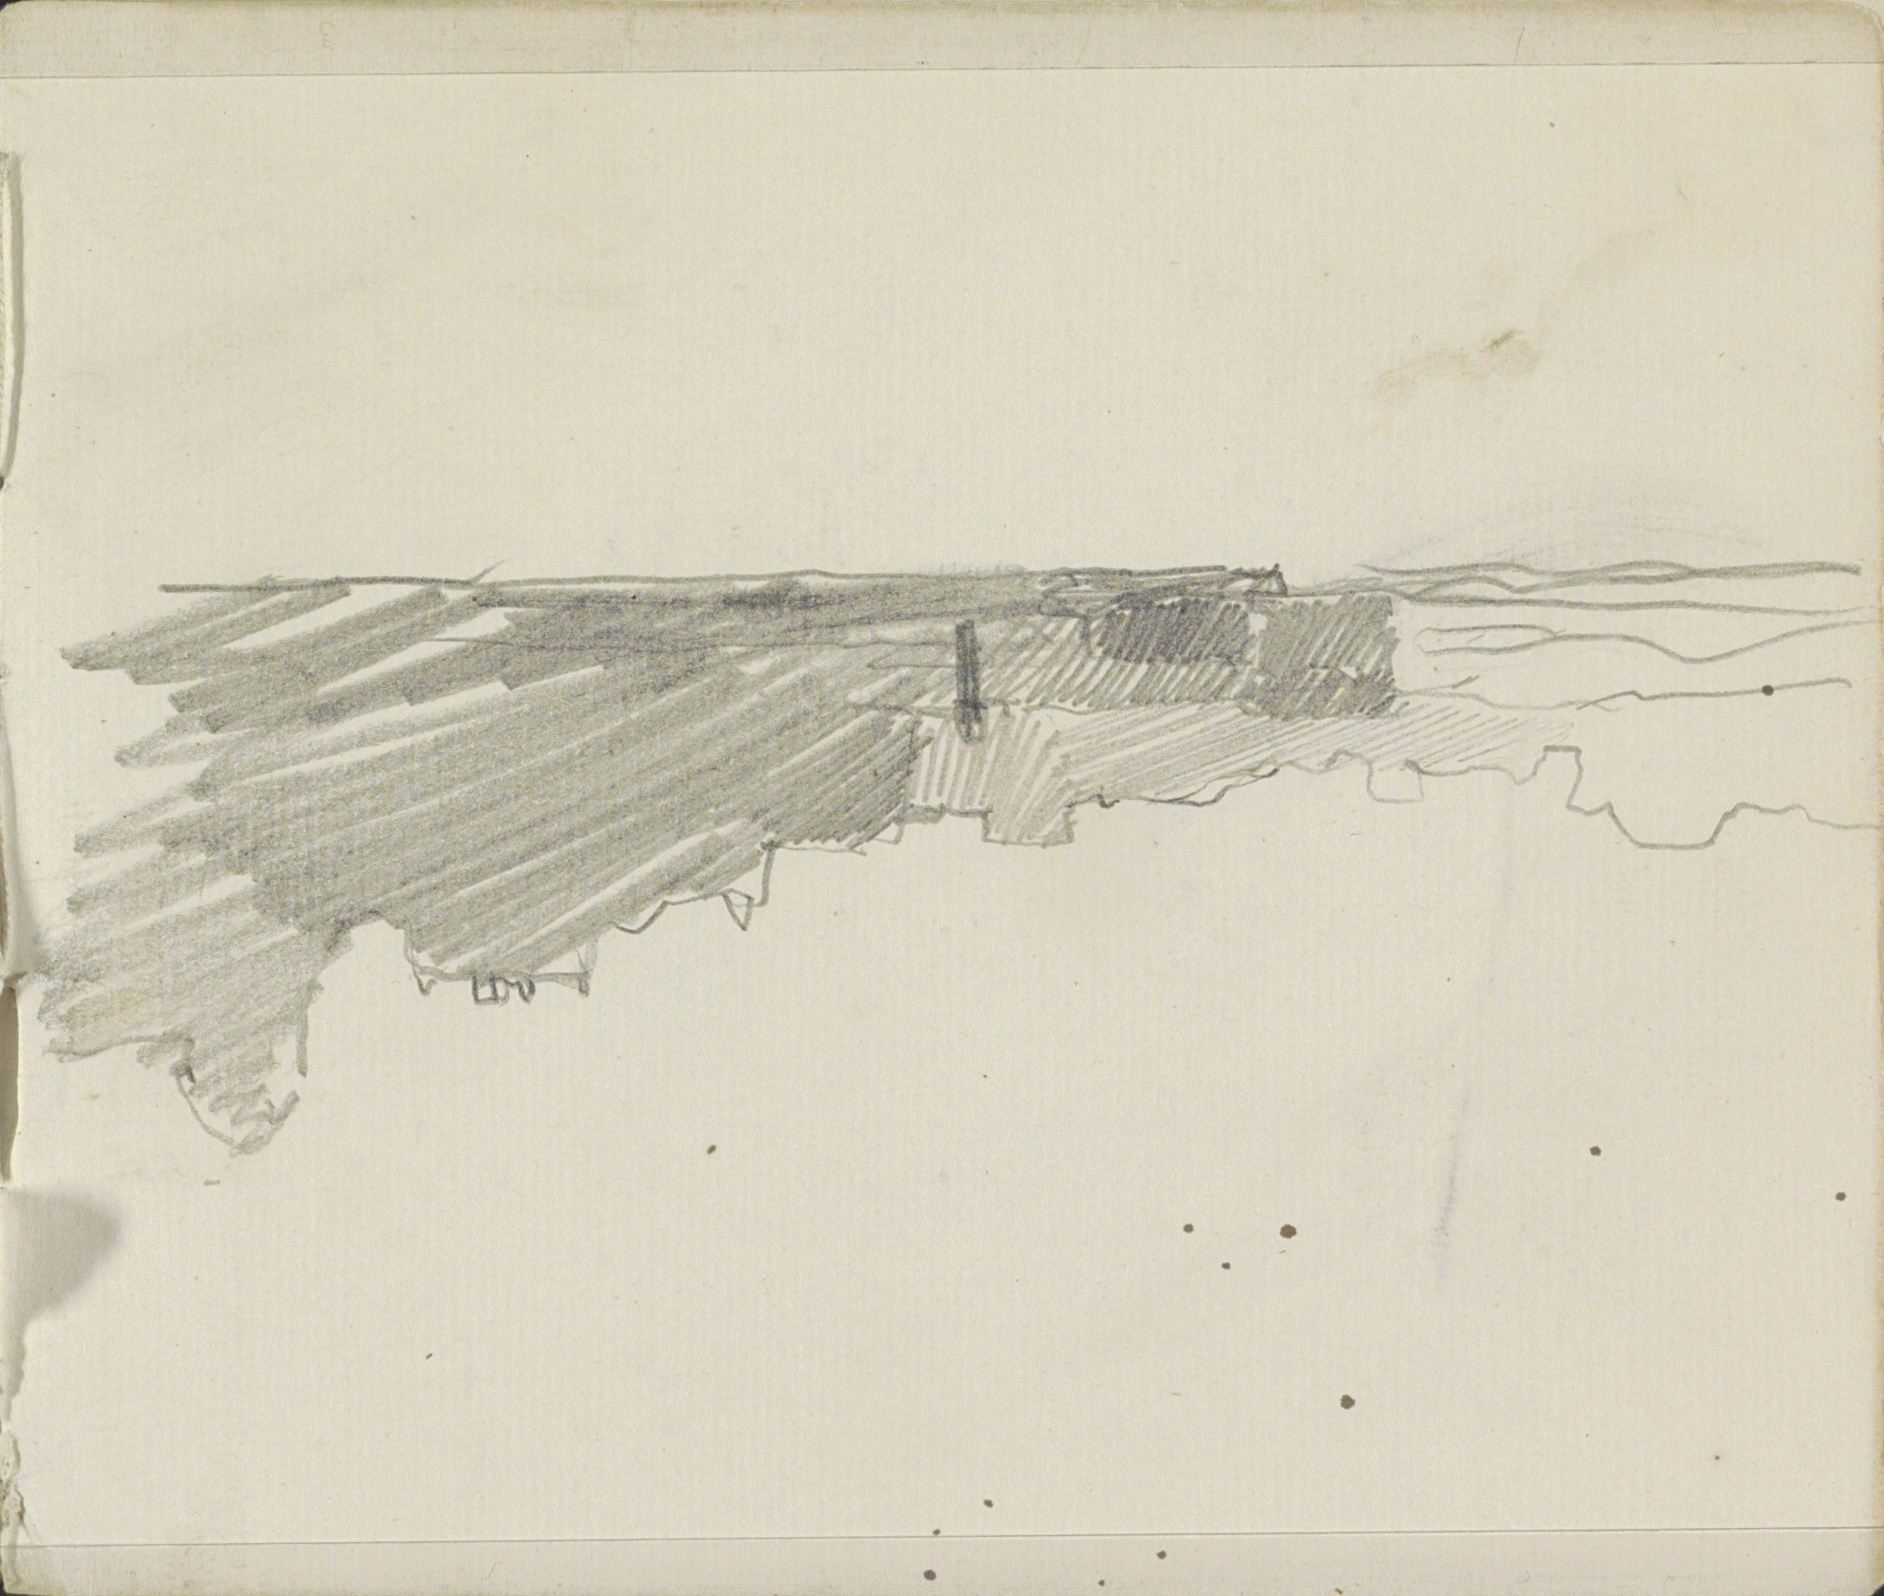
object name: sketchbook leaf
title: Stadsgezicht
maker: willem witsen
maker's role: draughtsman, painter, print maker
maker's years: 1860-1923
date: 1915-1920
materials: paper, pencil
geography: amsterdam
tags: city-view, and landscape with man-made constructions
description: Blad 1 recto uit een schetsboek met 12 bladen.